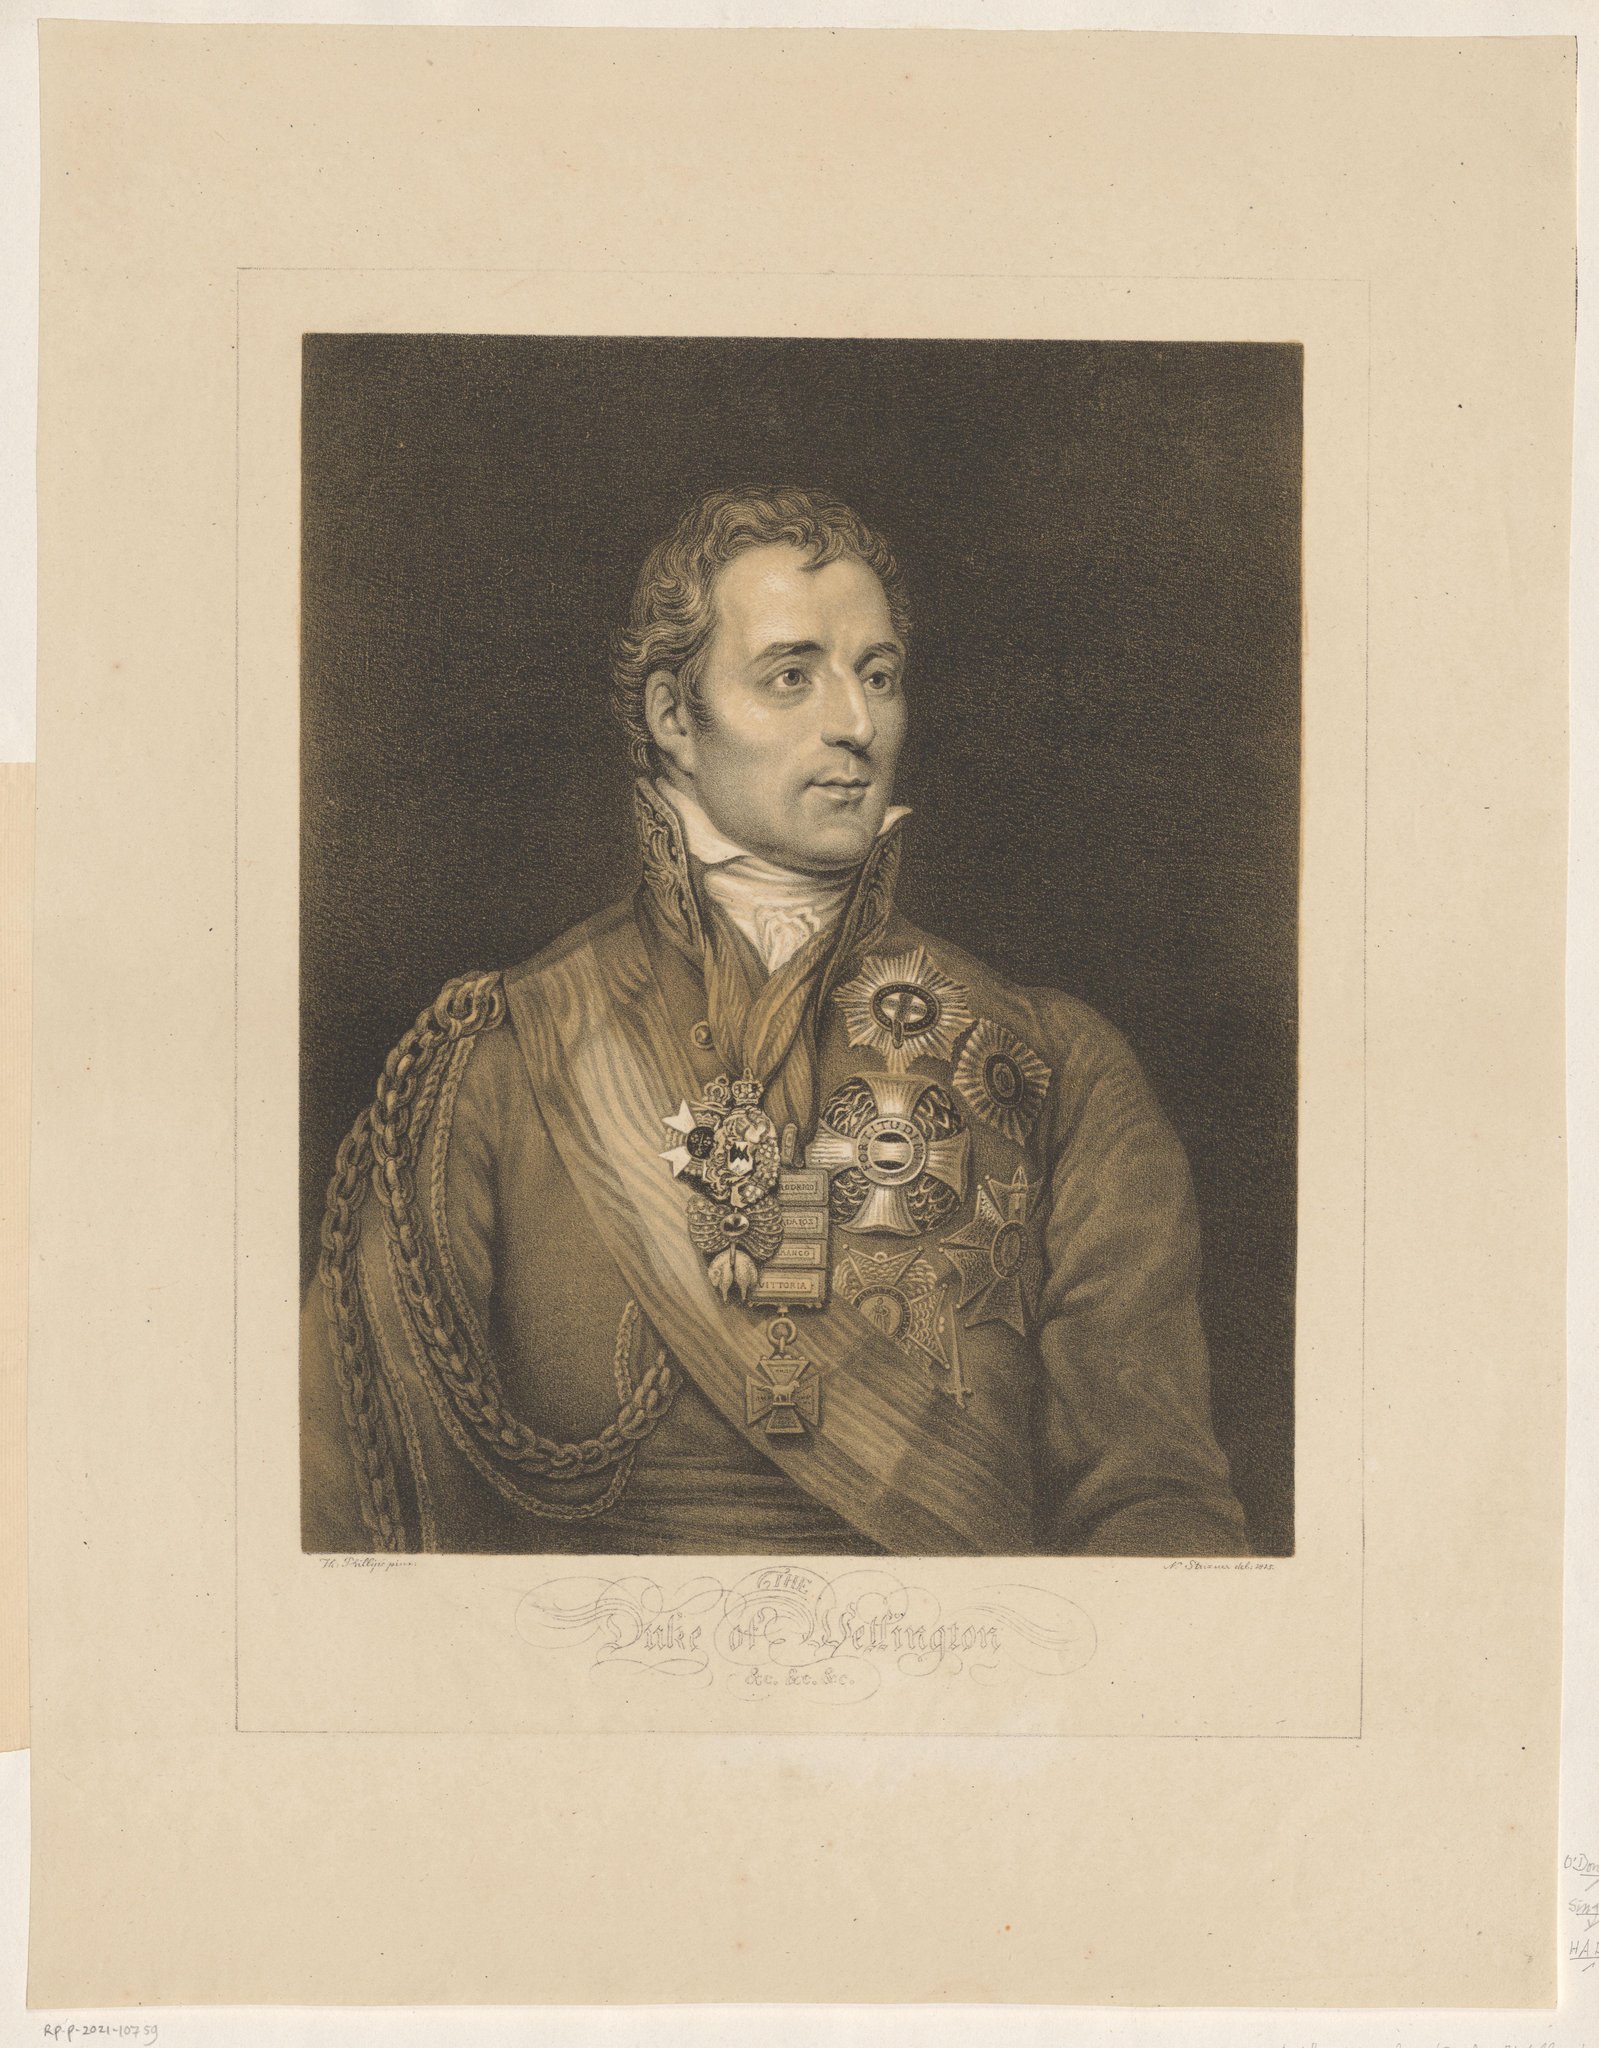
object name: print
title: Portret van Arthur Wellesley, hertog van Wellington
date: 1825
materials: paper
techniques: tone lithography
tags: walmer castle, arthur wellesley of wellington, adult man, historical persons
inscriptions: collector's mark: Lugt 2166, watermark: ‘M. de I.A. Huber’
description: Prent behoort mogelijk tot de serie 'Les Oeuvres Lithographiques, choix de dessins d'après les grands maitres de toutes les Ecoles, tirées du Musée de S.M. le roi de Bavière par Strixner, Piloty et Cie'. Deze serie werd door J. Stunz in München in 72 delen van elk zes bladen gepubliceerd tussen 1810 en 1816; in totaal 432 prenten. Later is hierop nog een vervolg uitgebracht met prenten naar schilderijen.